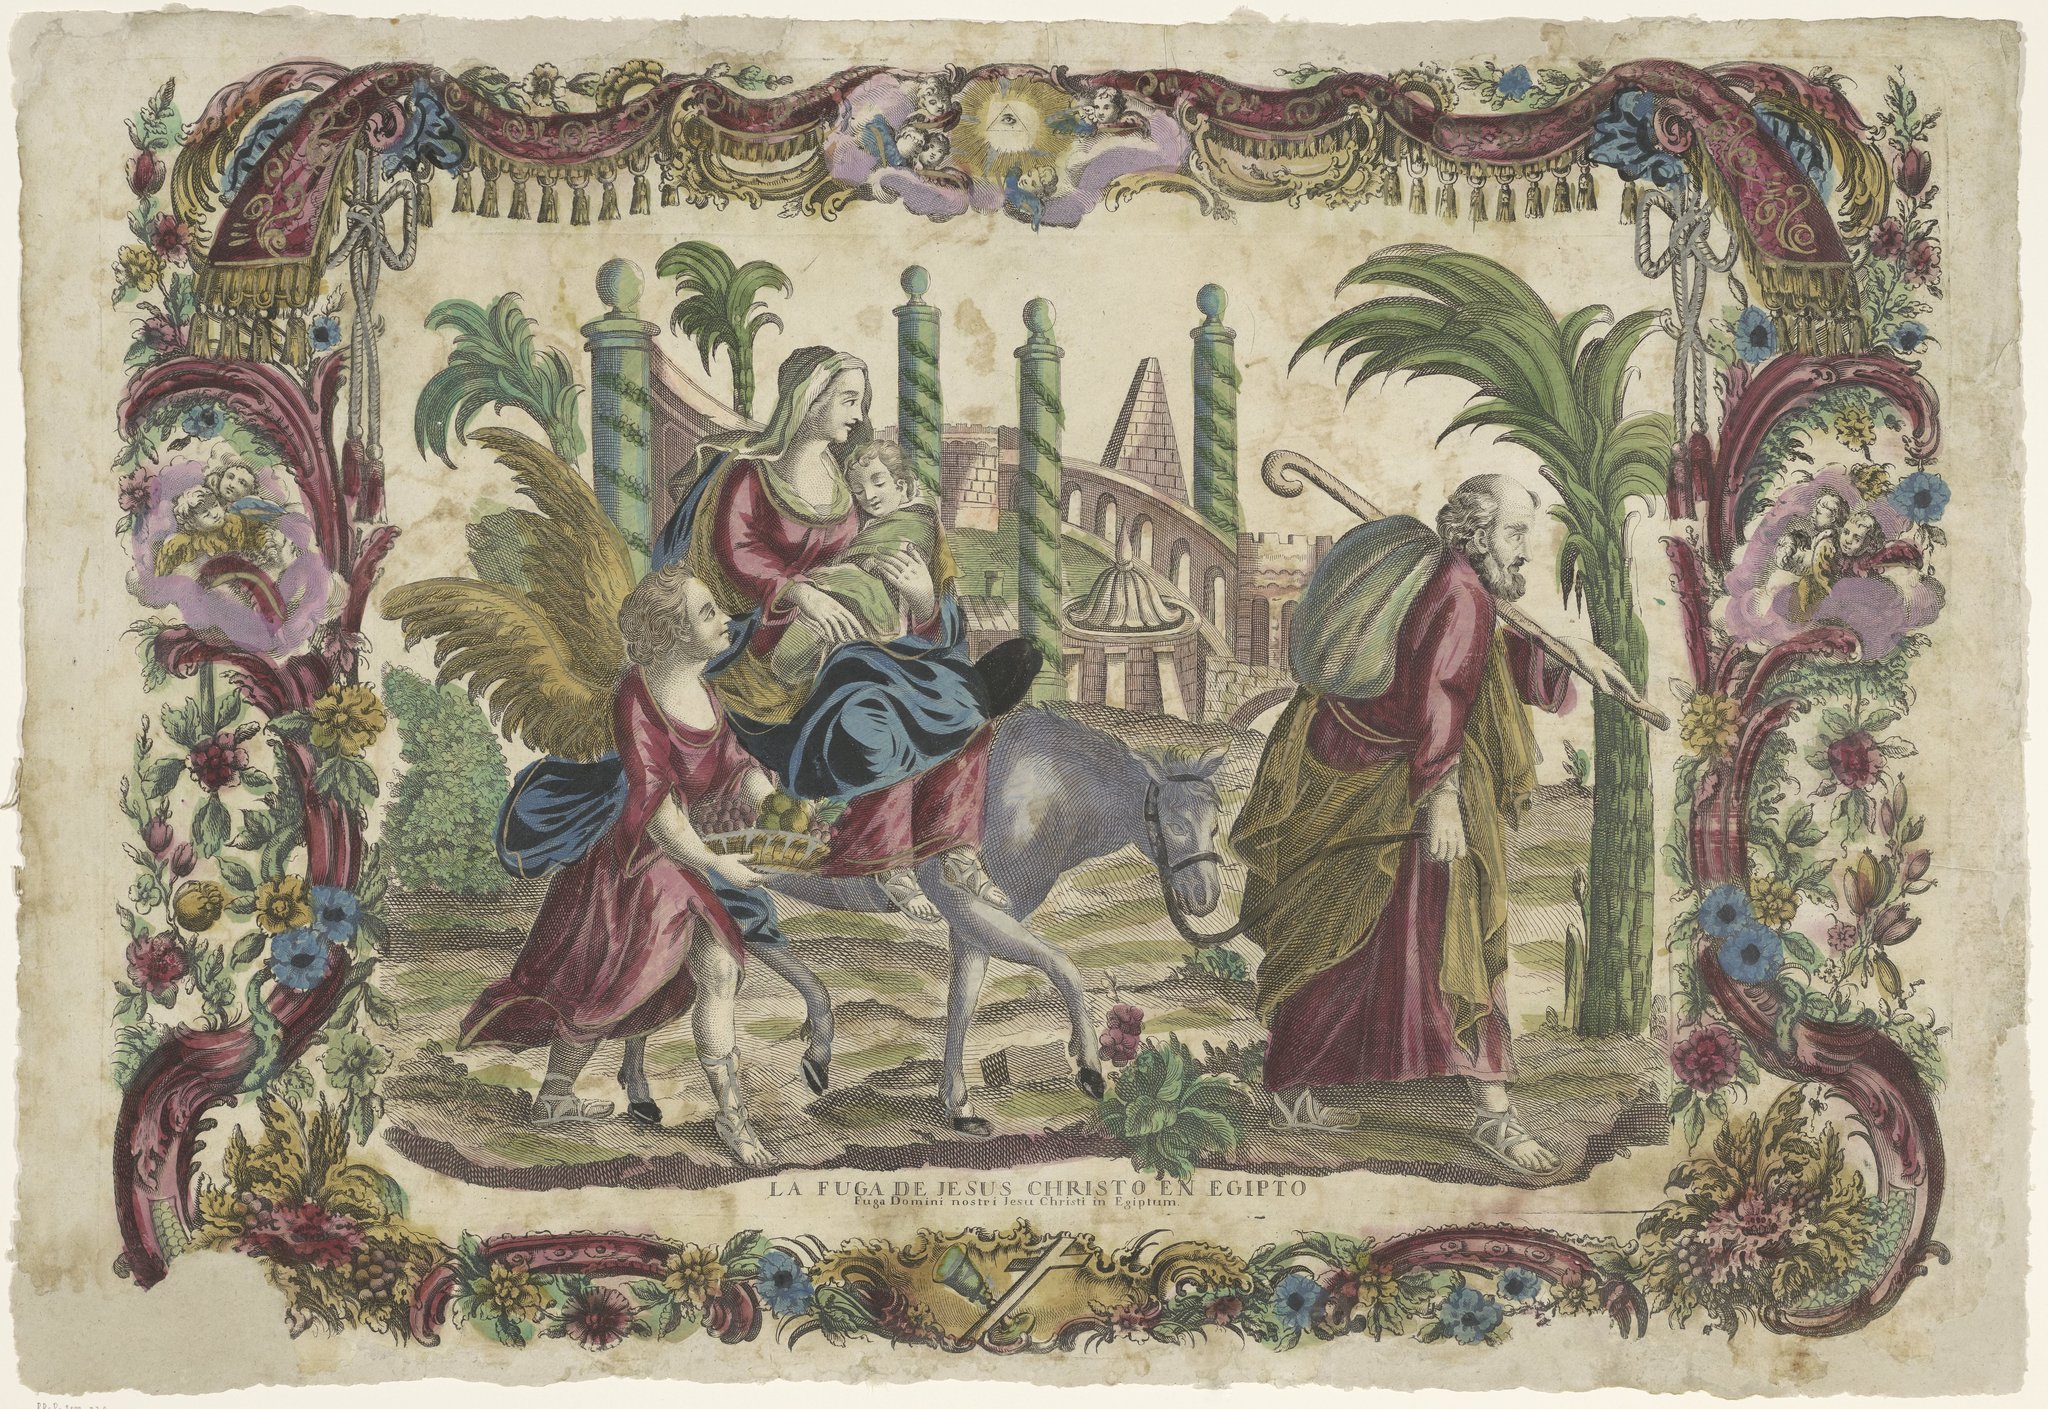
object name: print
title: De vlucht naar Egypte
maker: giovanni volpato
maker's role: ceramicist, print maker, printer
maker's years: 1735-1803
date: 1700-1799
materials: paper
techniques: colour, engraving, etching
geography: italy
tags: ornaments ~ art, the flight into egypt: mary, joseph, the child (and sometimes others) on their way; mary usually riding on an ass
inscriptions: collector's mark: Lugt 2760, collector's mark: Lugt 2228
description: In een landschap met palmbomen zit Maria met Kind op de ezel, die wordt geleid door Jozef. Jozef draagt een stok en knapzak op zijn schouder. Naast de ezel loopt een engel. Titel in twee talen onder voorstelling. De scène is gevat in een ornamentrand met bloemen en cherubijnen.